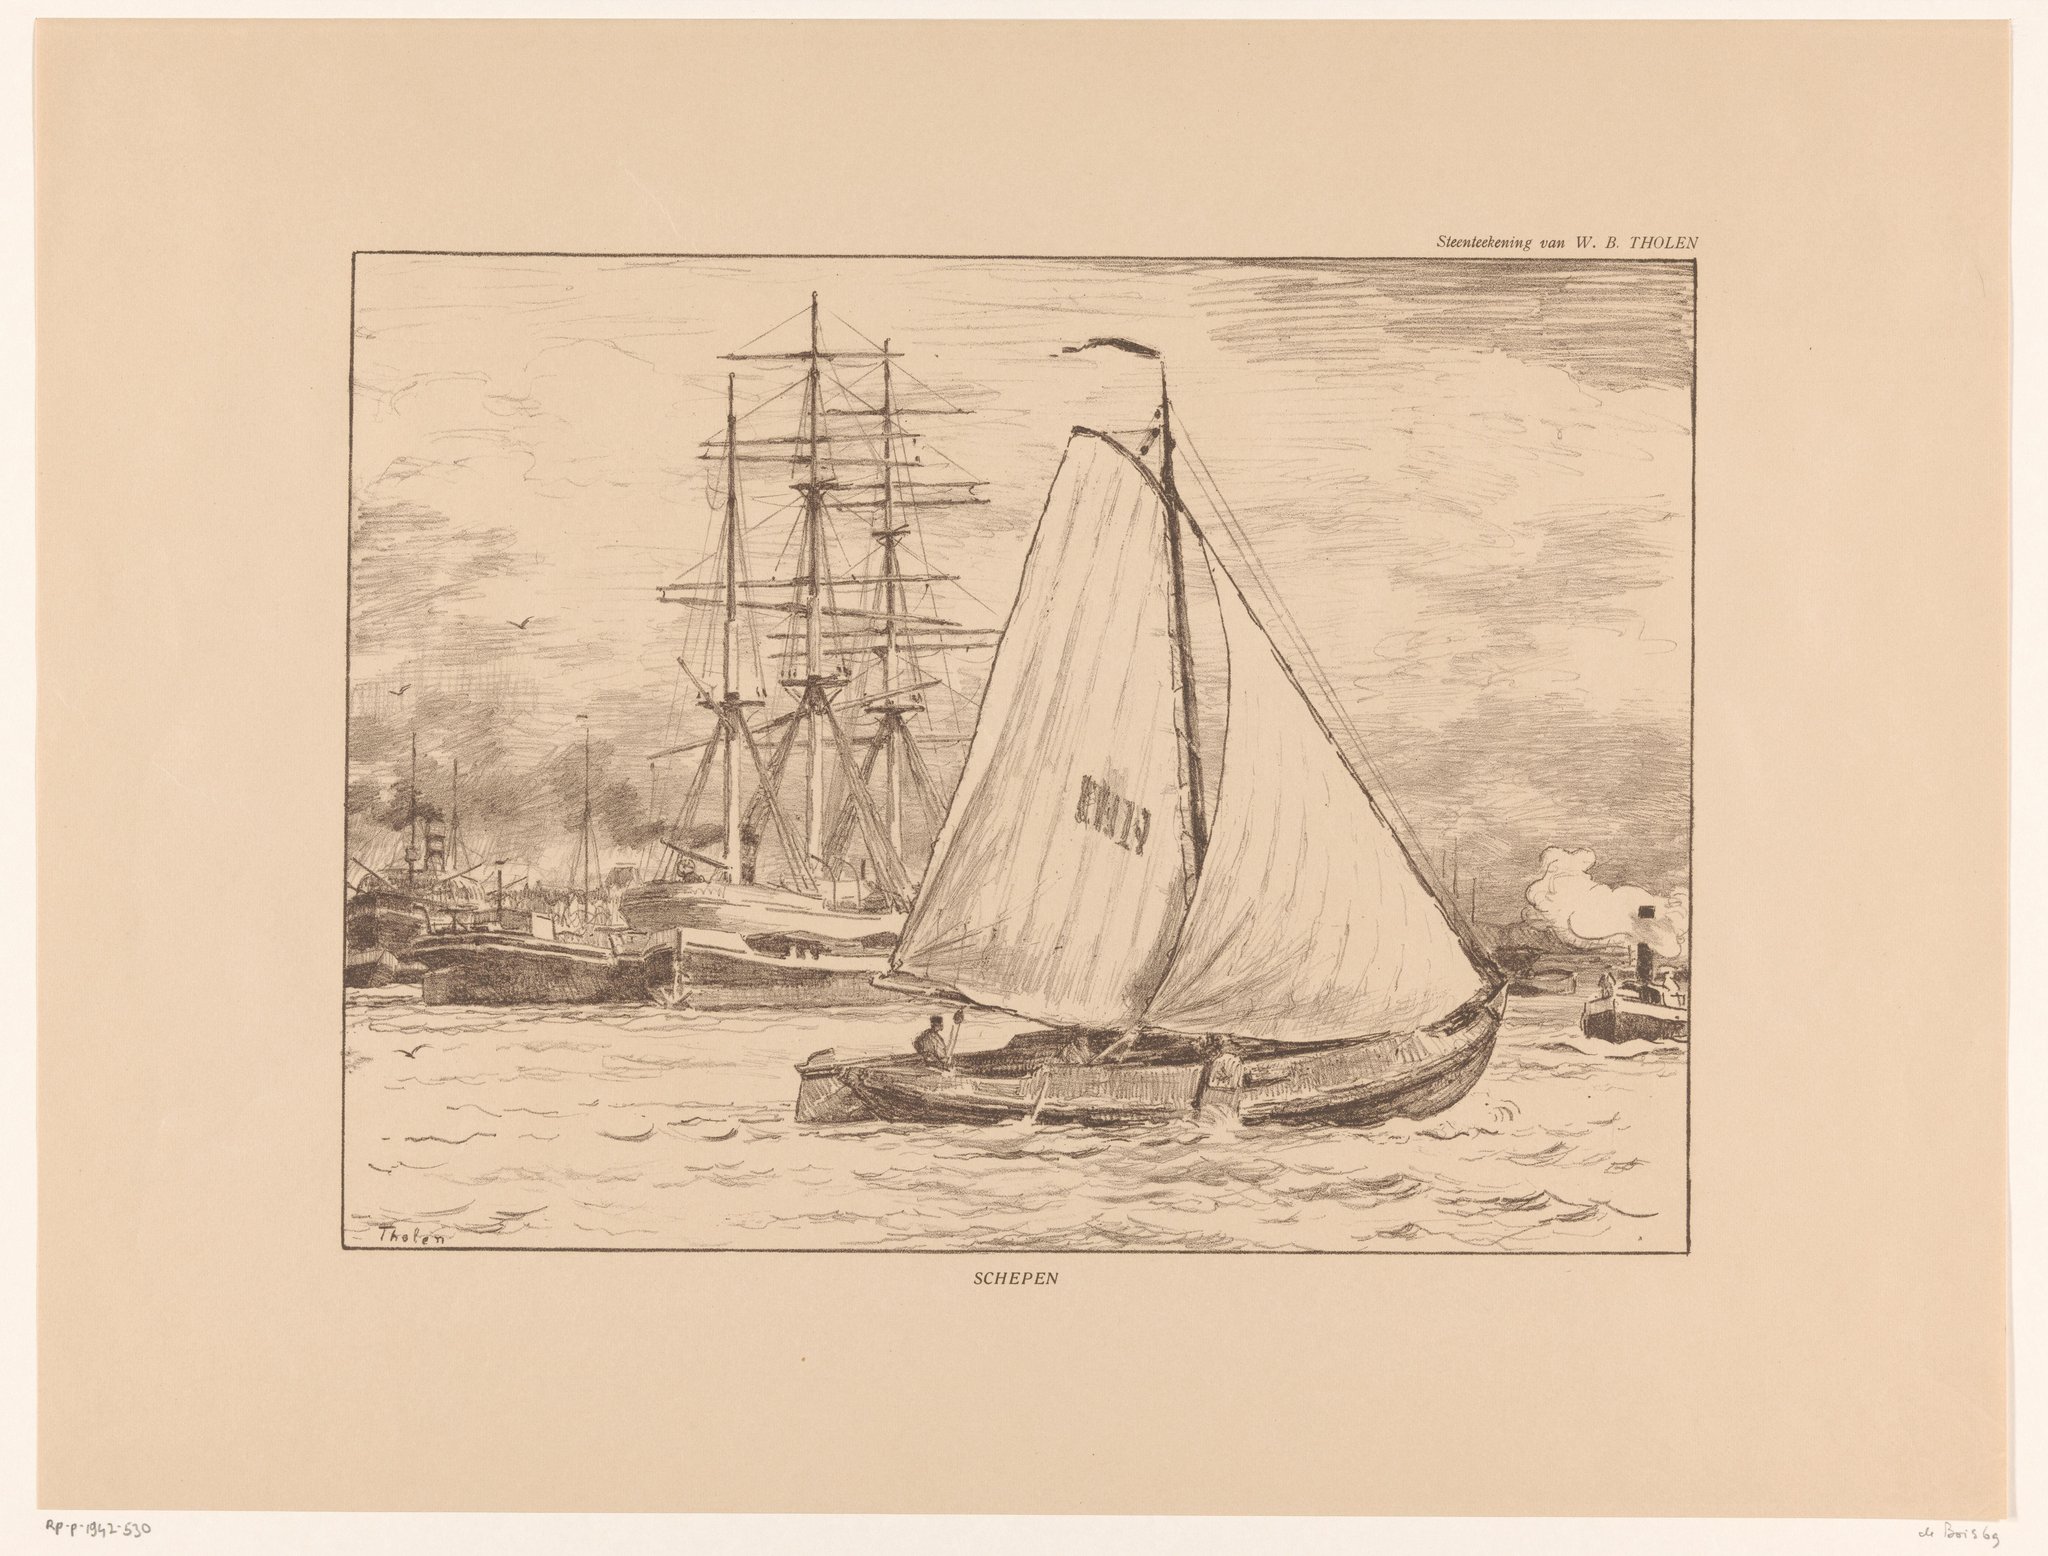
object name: print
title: Schepen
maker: willem bastiaan tholen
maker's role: draughtsman, painter, print maker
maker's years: 1860-1931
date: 1915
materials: paper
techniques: lithograph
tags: harbour, sailing-ship, sailing-boat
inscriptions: collector's mark: Lugt 2228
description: Haven met tal van schepen, onder andere een zeilende schokker, een driemaster en een sleepboot.